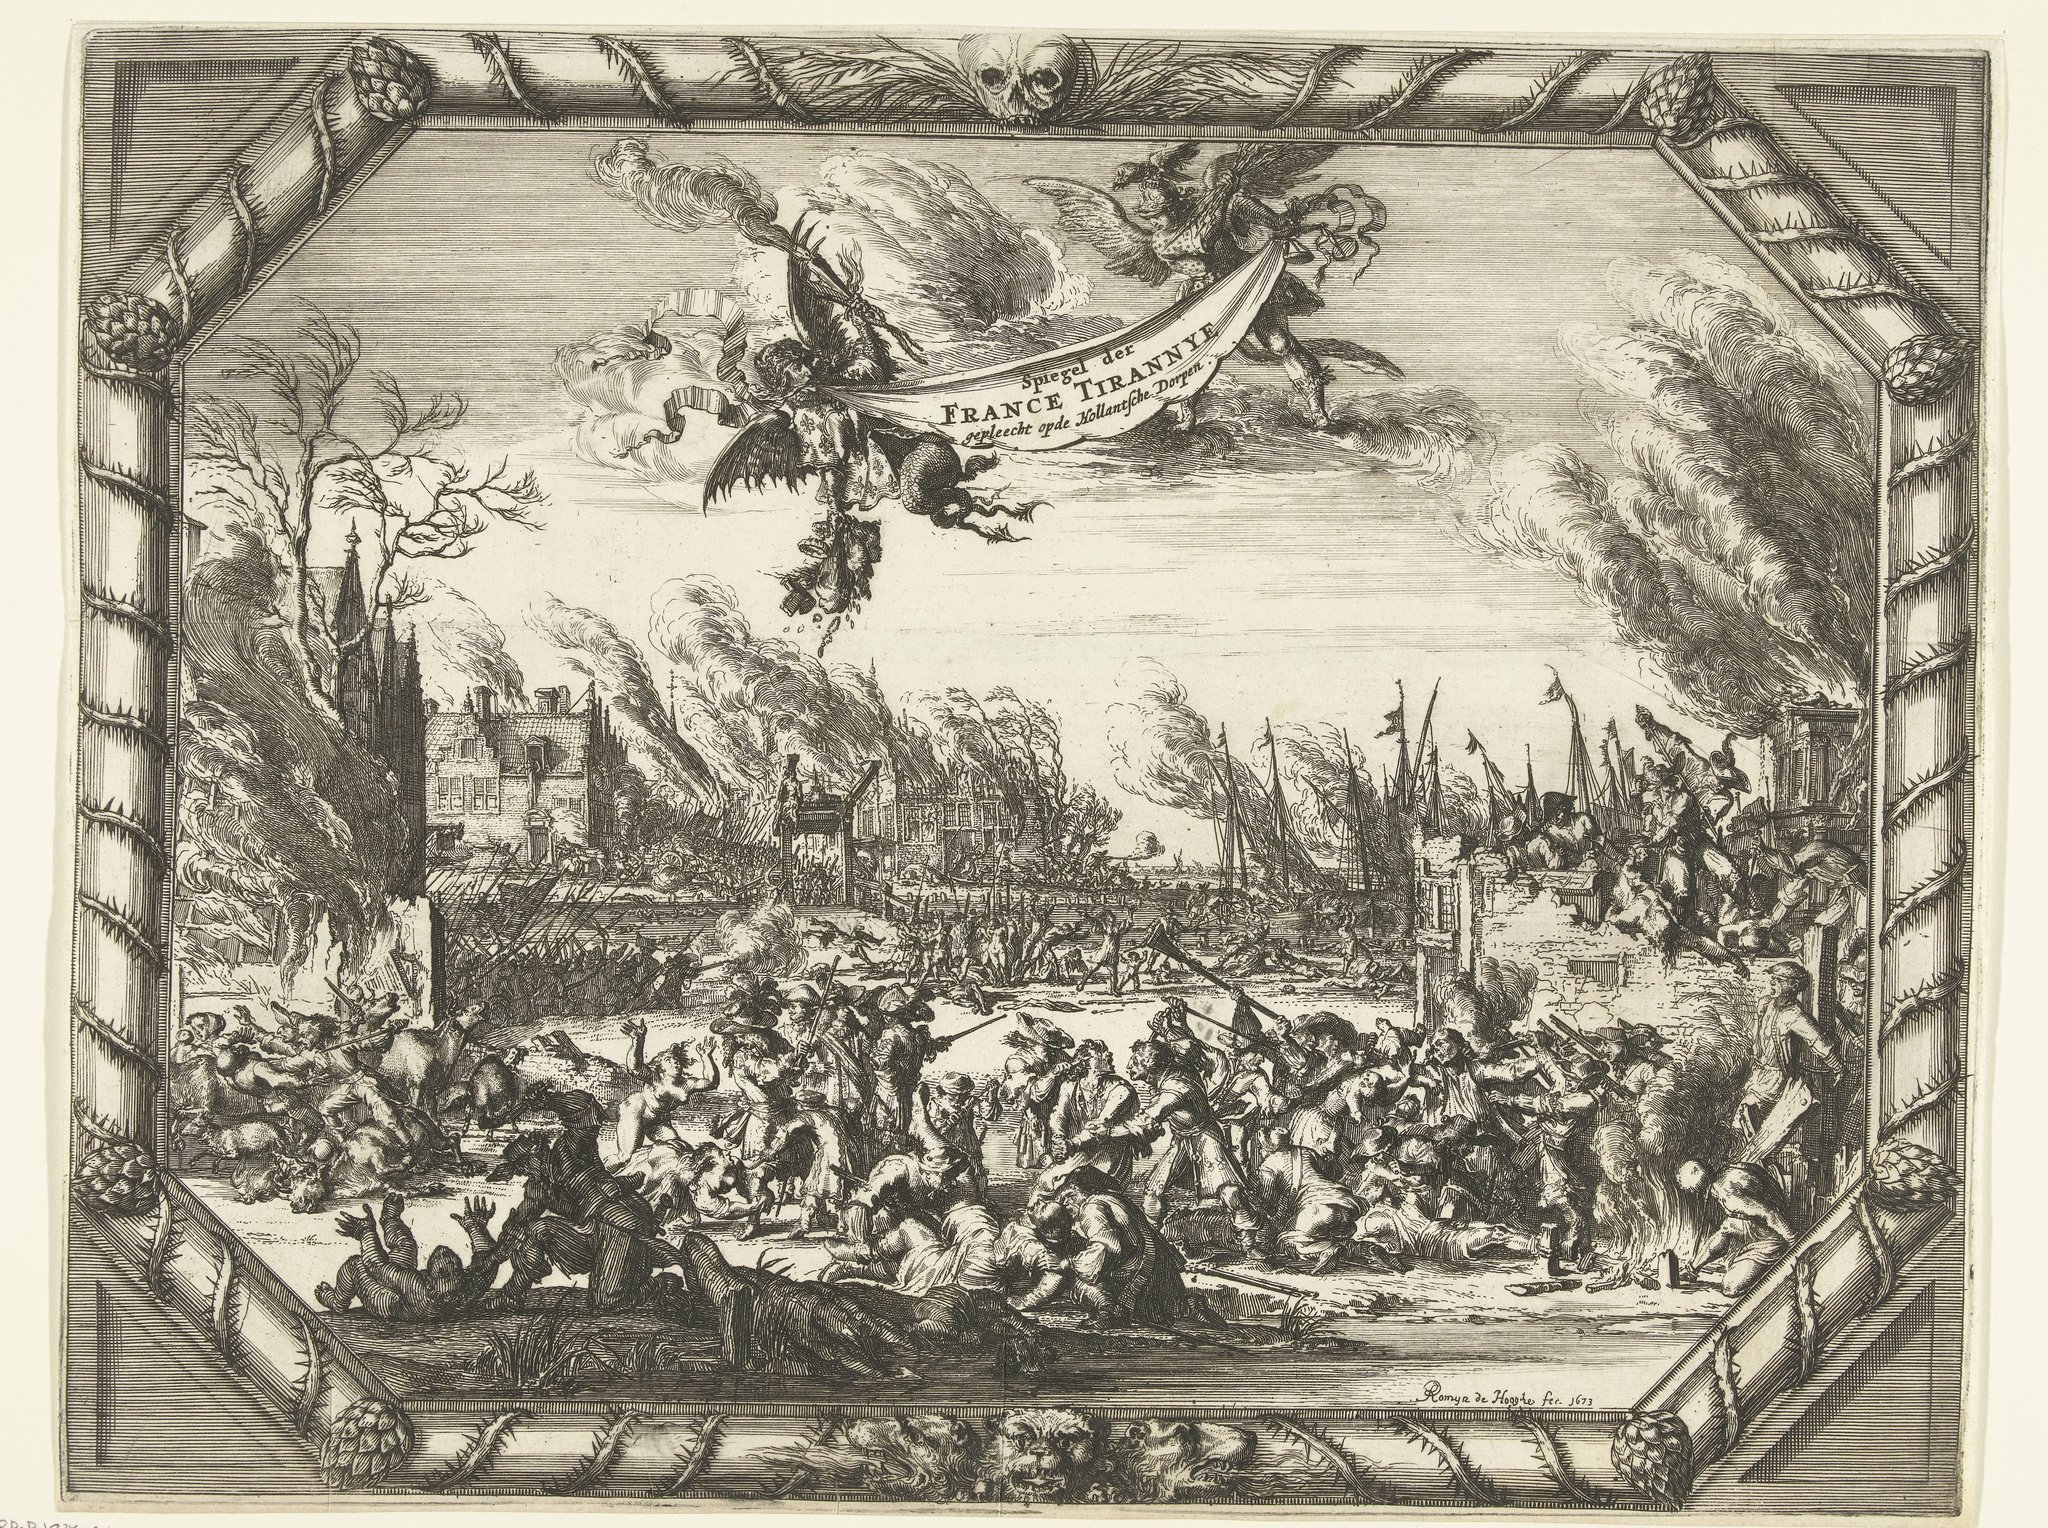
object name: print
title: Spiegel der France Tirannye gepleecht opde Hollantsche Dorpen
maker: romeyn de hooghe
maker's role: draughtsman, goldsmith, painter, print maker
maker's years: 1645-1708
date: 1673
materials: paper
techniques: engraving, etching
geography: netherlands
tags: plundering ~ soldiers, violent death, being killed; being mishandled and maltreated; seeking death, massacre ~ war, bodegraven, rampjaar (disaster year)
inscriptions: date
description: Voorstelling van de wreedheden gepleegd door de Franse troepen in de Hollandse dorpen Bodegraven en Zwammerdam, eind december 1672. Het opschrift wordt in de lucht gedragen door personificaties van de oorlog en de Franse wreedheid. Links het brandende dorp Zwammerdam met de ophaalbrug. De voorstelling is gevat in een octogonale lijst, omwonden door doornen en bekroond met een doodshoofd.